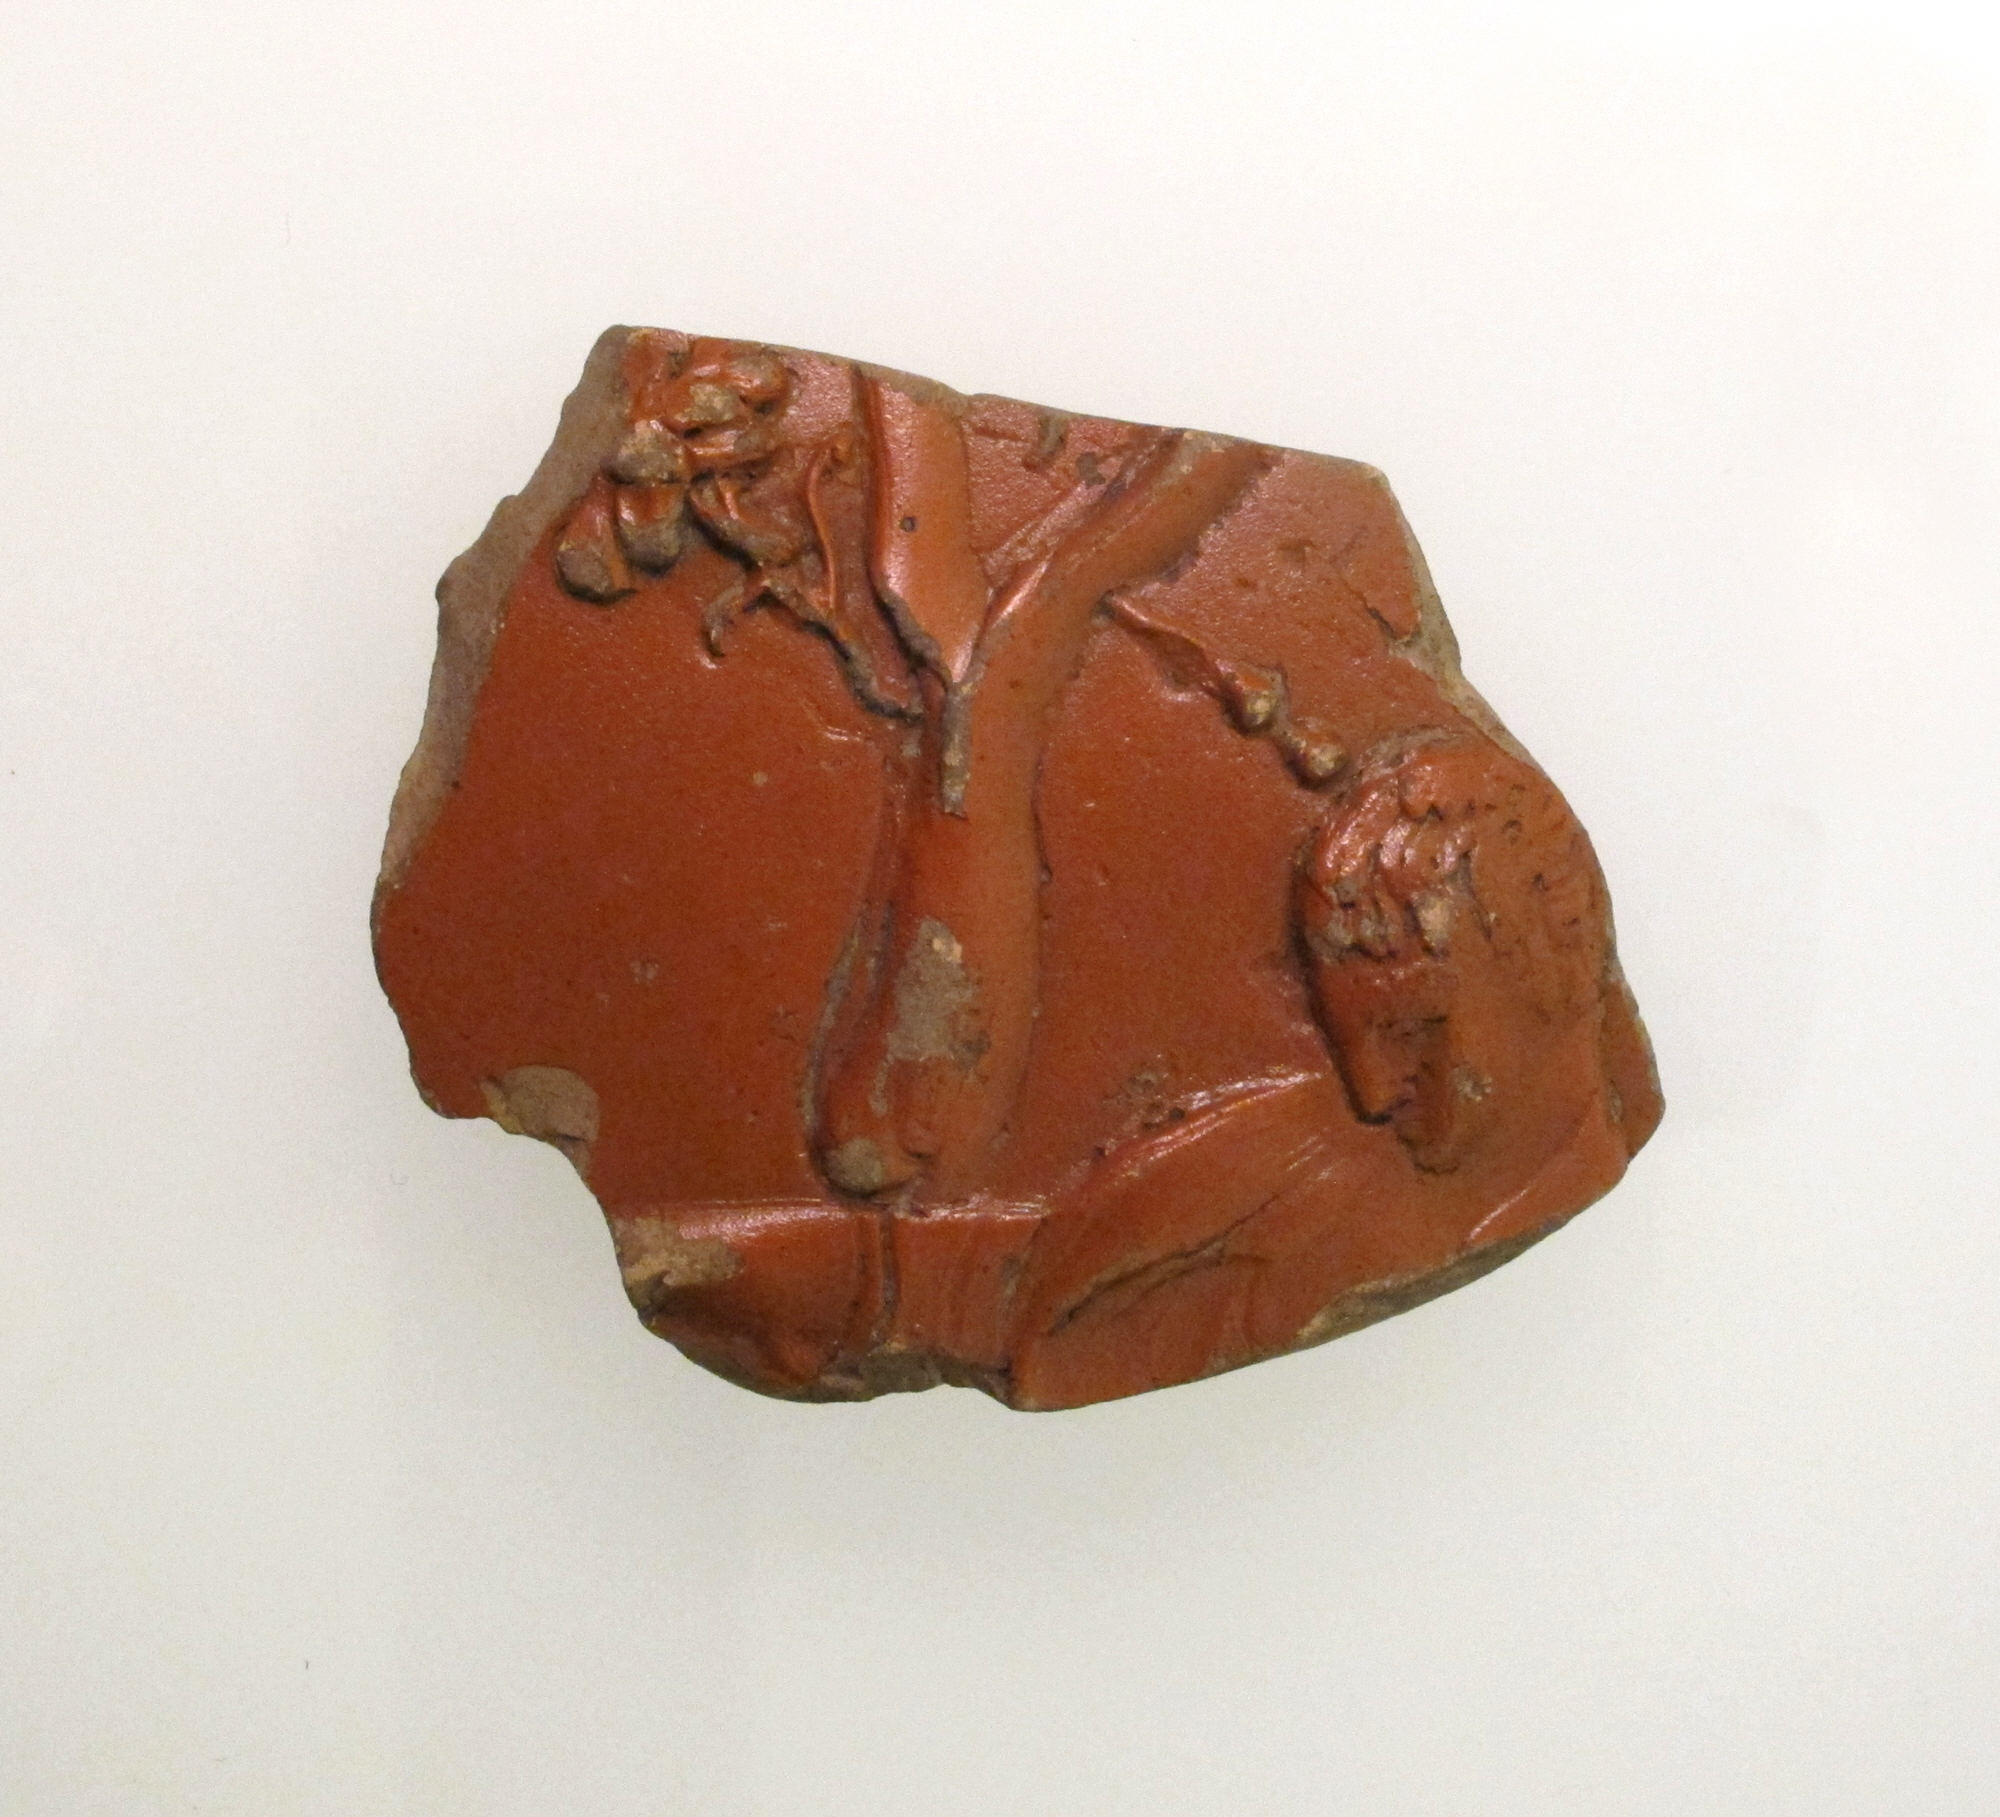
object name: vase fragment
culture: roman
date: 100 BCE-100 CE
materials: terracotta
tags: maenads,trees